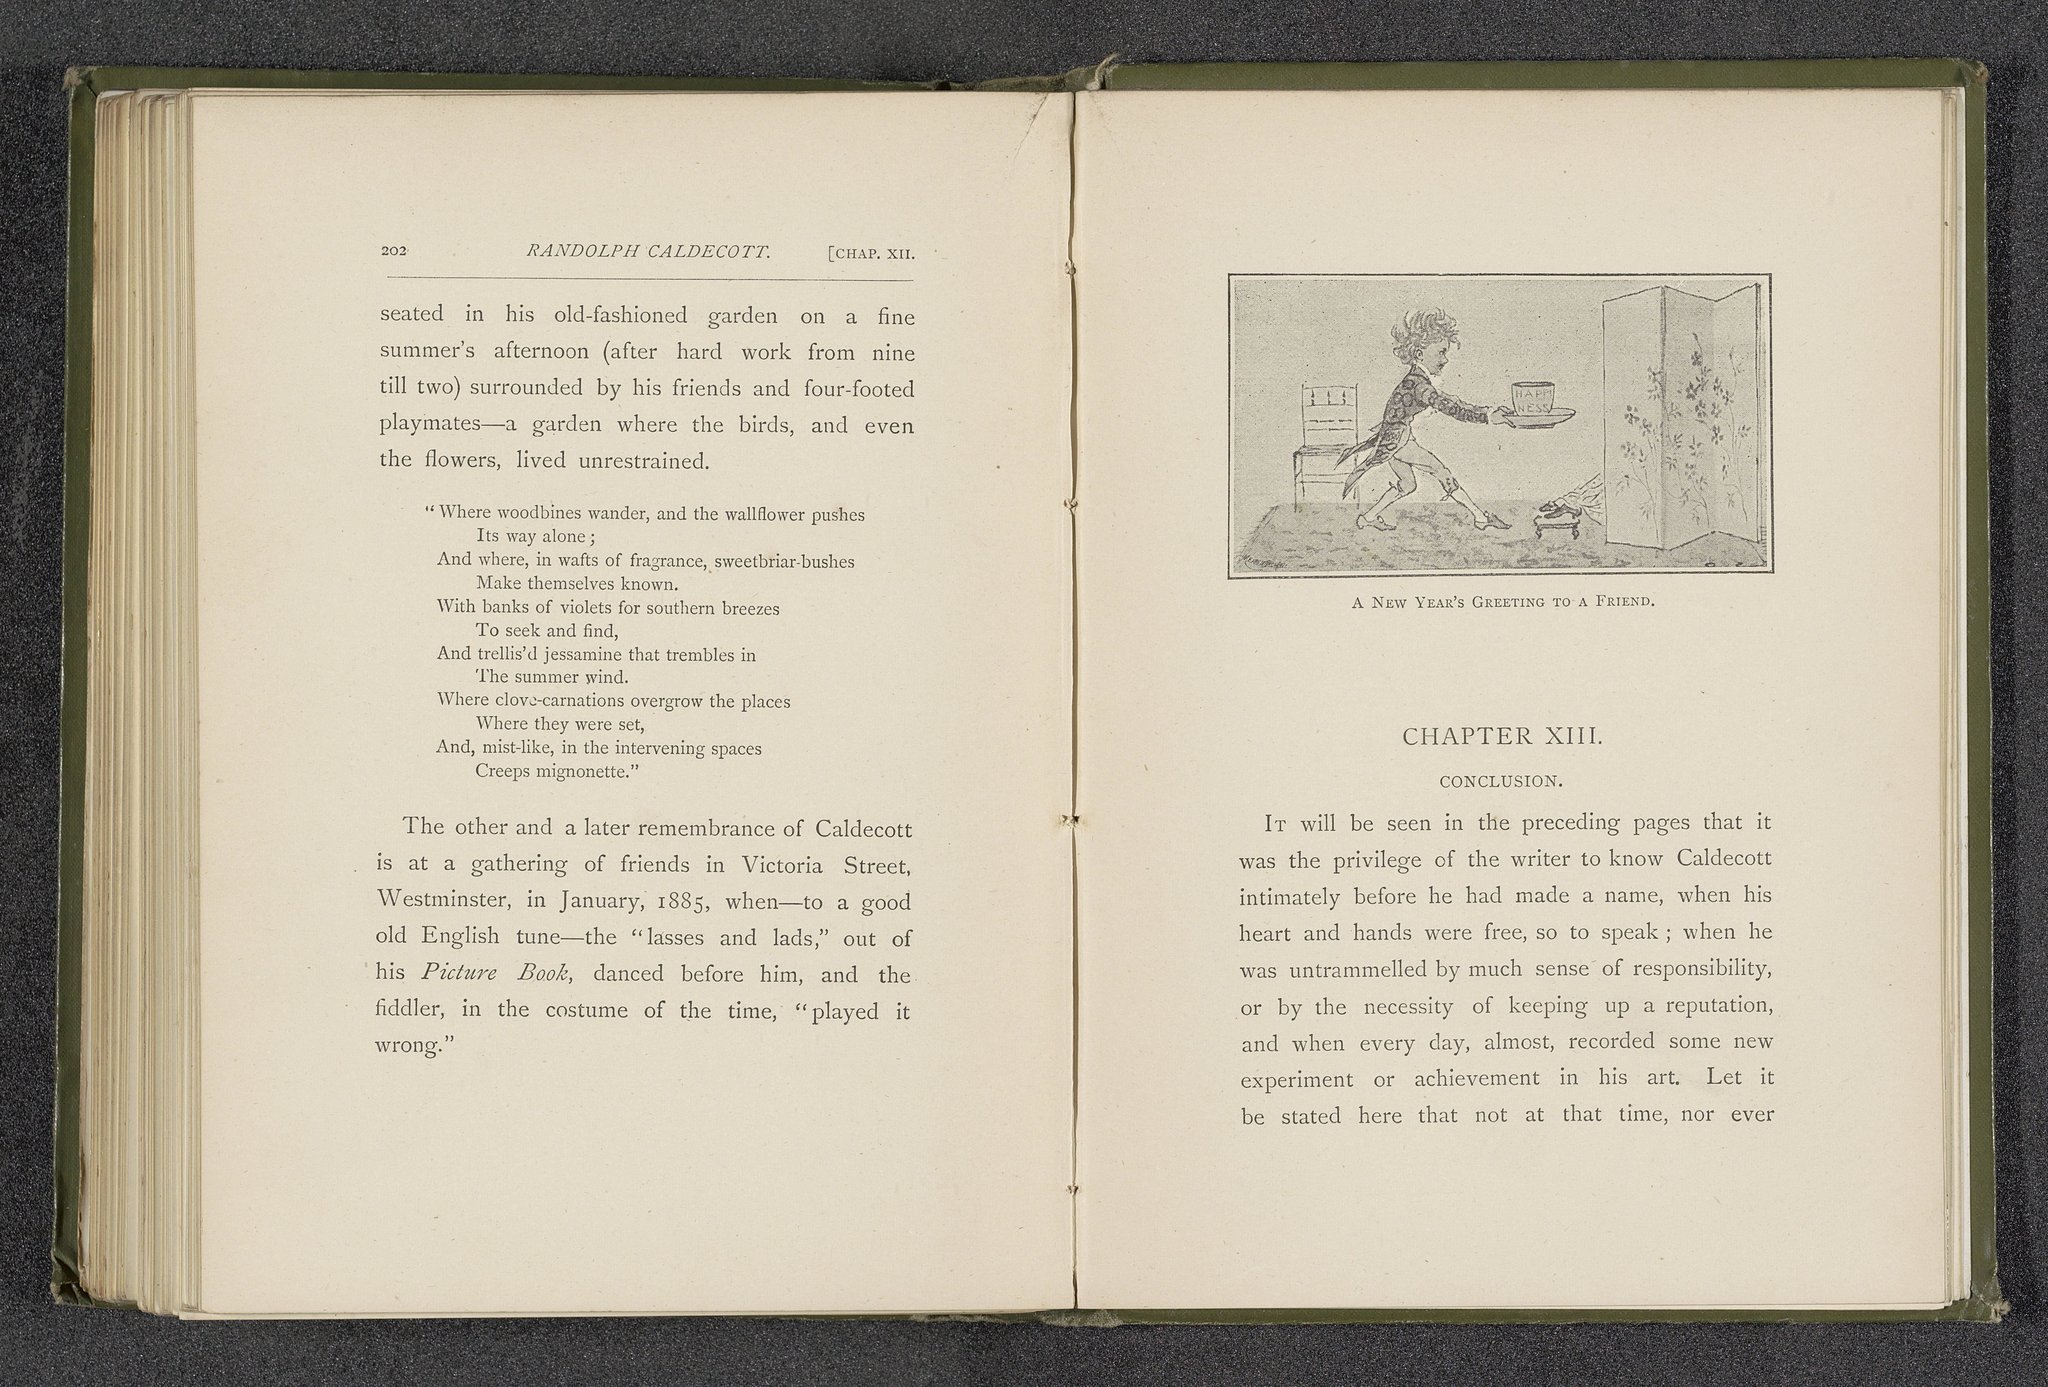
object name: page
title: Fotoreproductie van een nieuwjaarswens door Randolph Caldecott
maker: Anonymous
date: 1877-1887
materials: paper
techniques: autotype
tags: animated cartoon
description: Man die een kop met het woord: Happiness, naar een figuur achter een kamerscherm brengt.